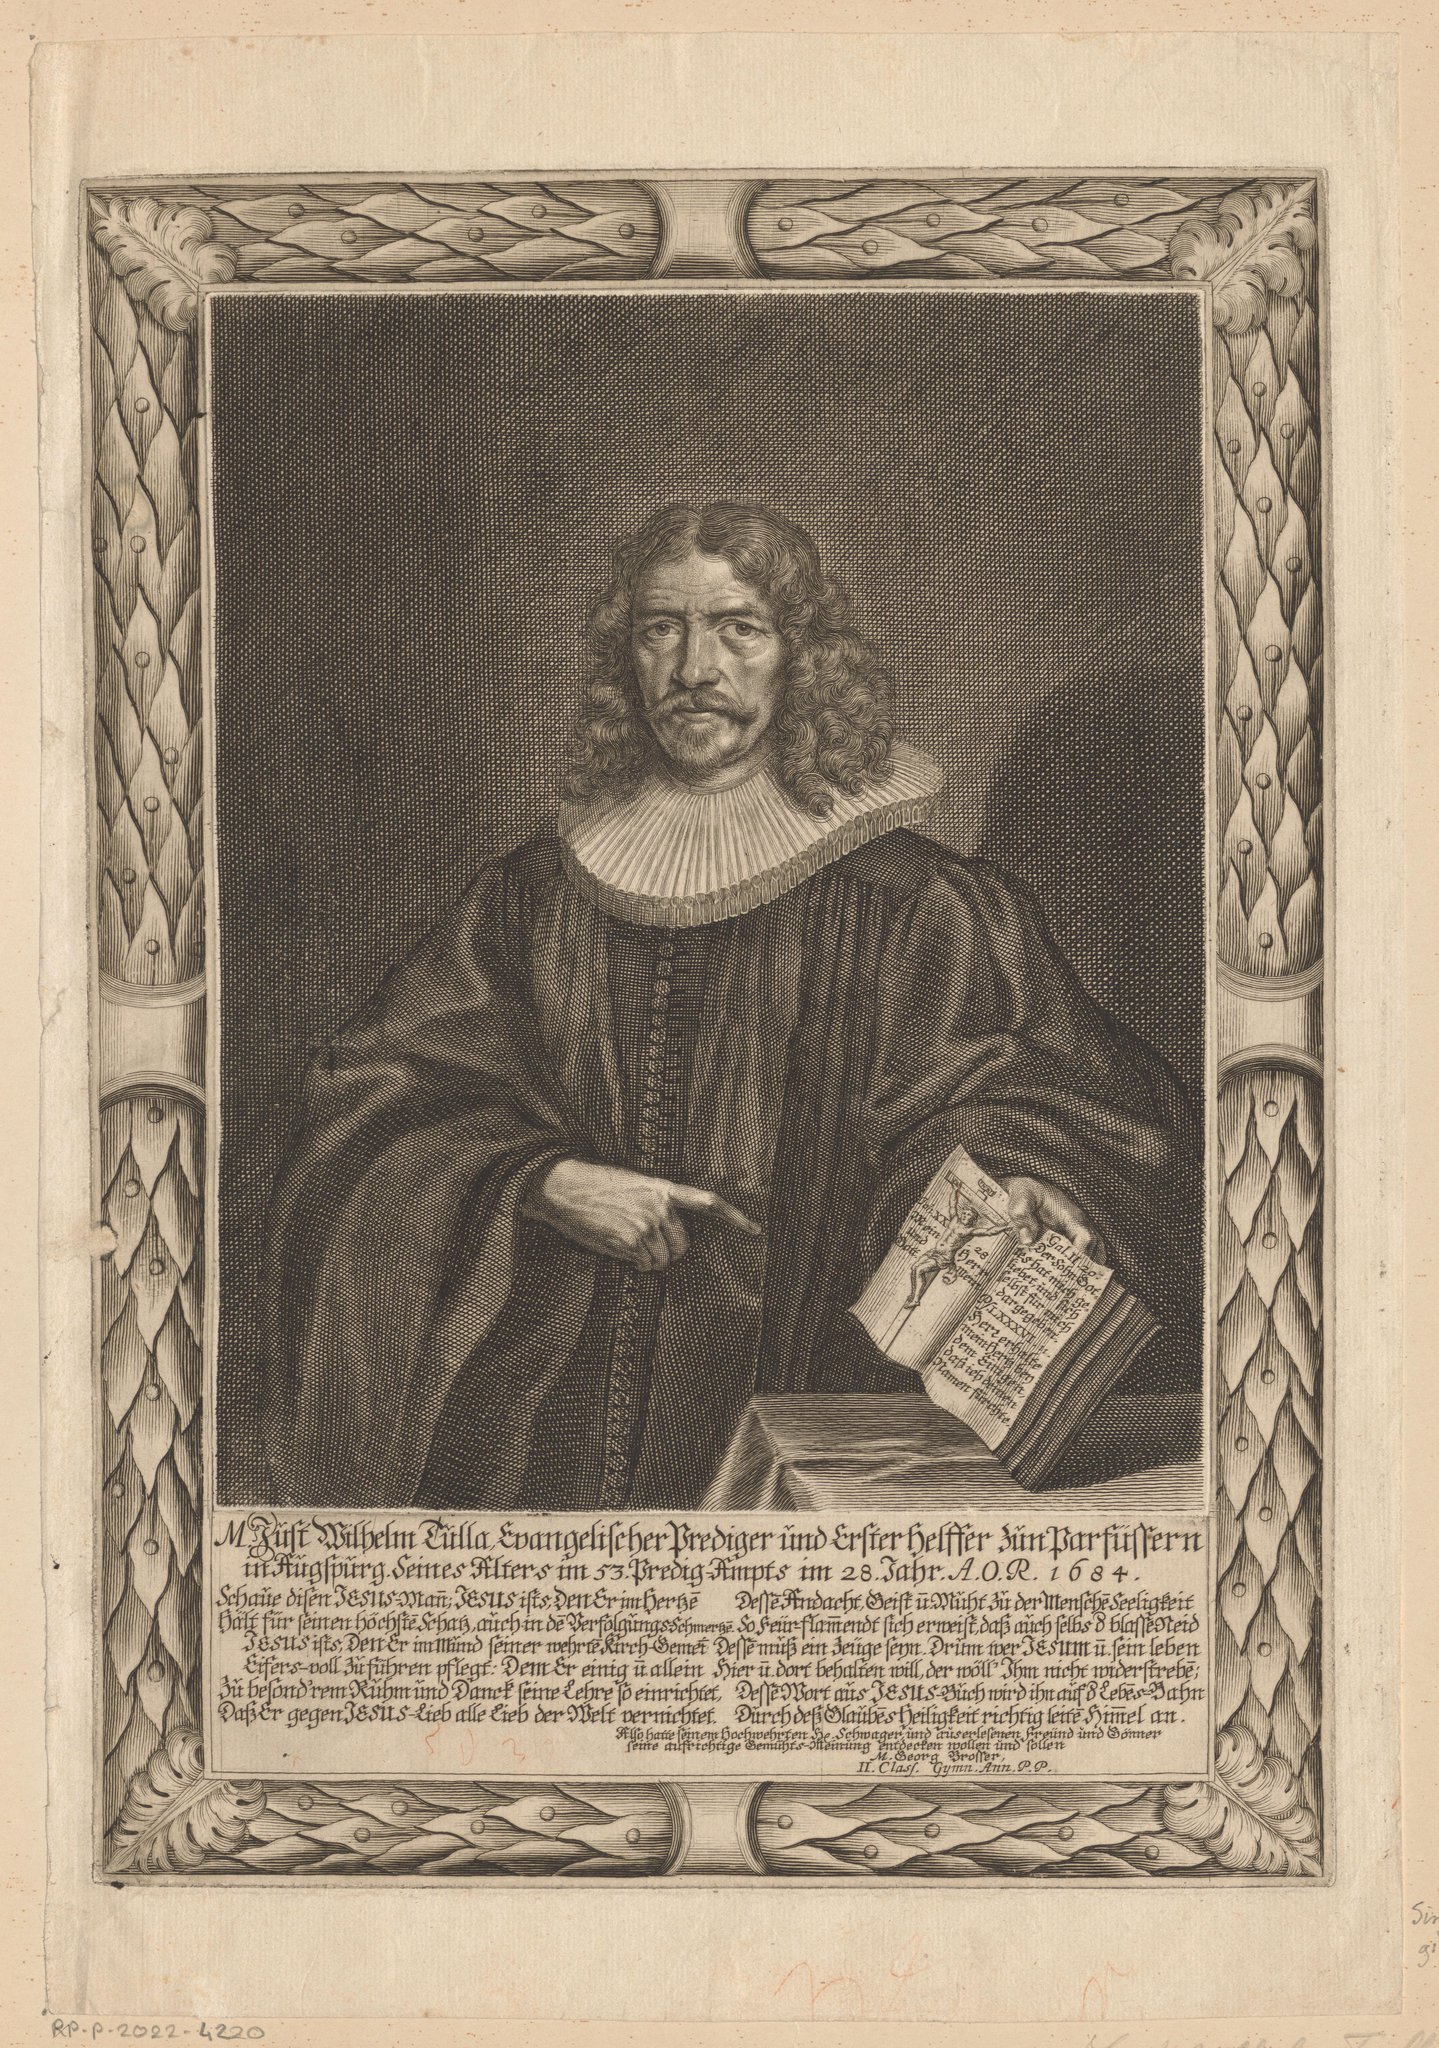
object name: print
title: Portret van Justus Wilhelm Tulla op 53-jarige leeftijd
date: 1684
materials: paper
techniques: engraving, etching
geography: augsburg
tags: germany, augsburg, theologian, historical persons, book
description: Met omlijsting gedrukt van een aparte plaat en twaalfregelig onderschrift in het Duits.